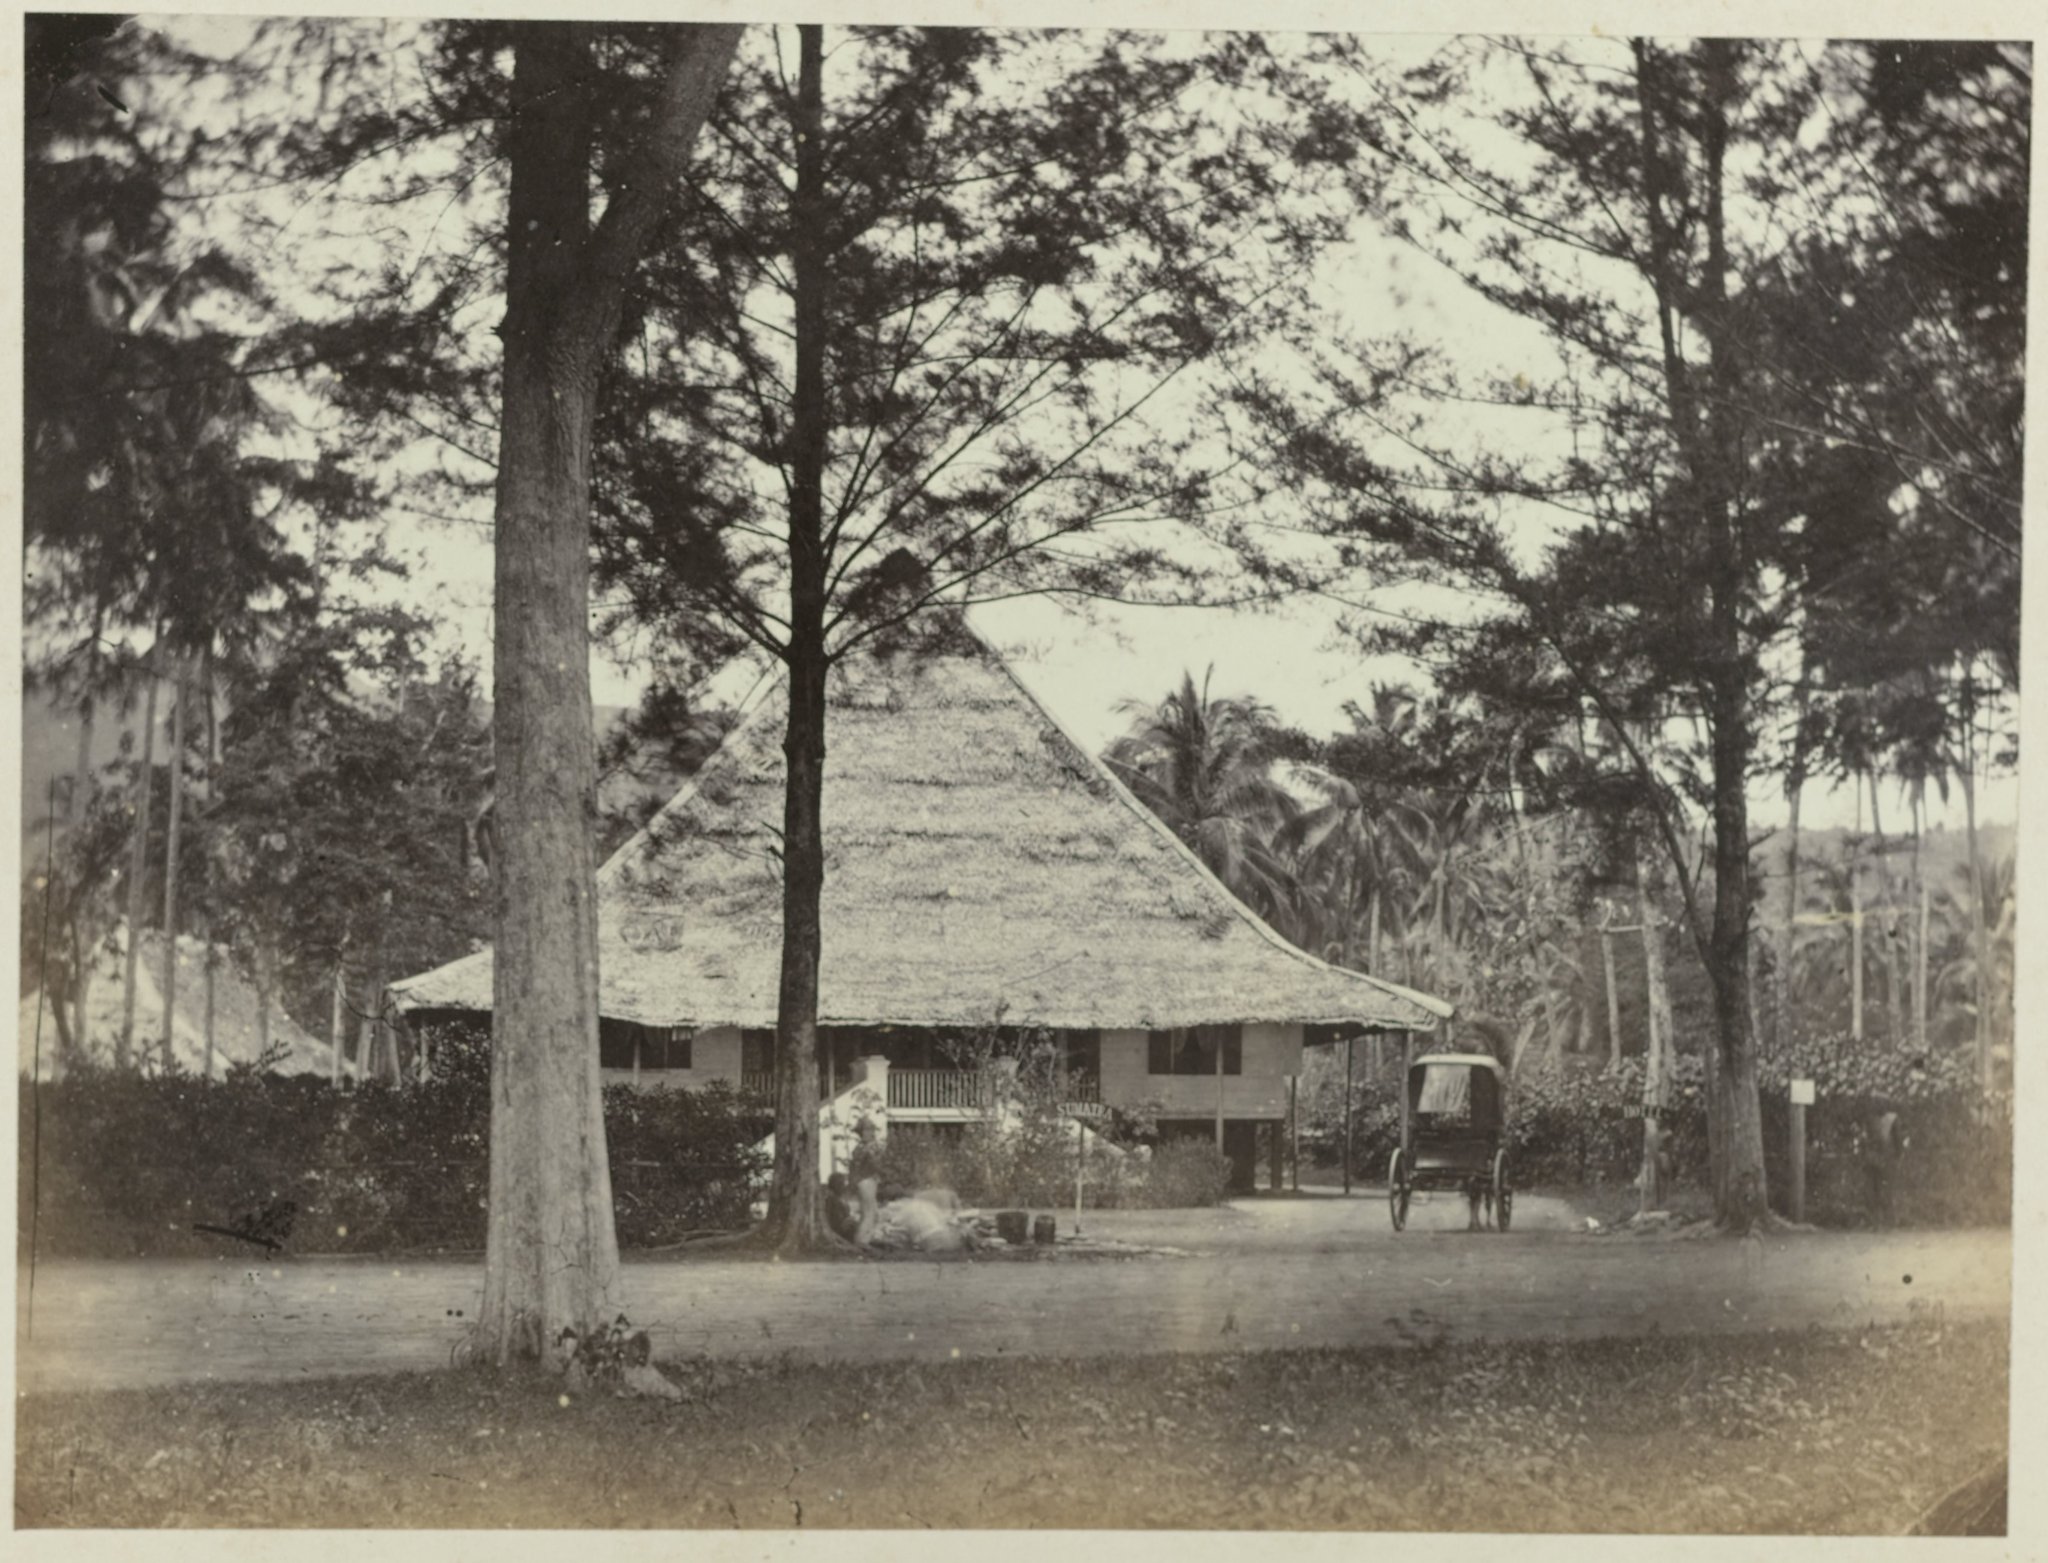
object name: photograph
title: Huis met koets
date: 1863-1869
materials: photographic support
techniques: albumen print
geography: padang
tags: country-house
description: Gezicht op een rijtuig voor Hotel Sumatra te Padang. Onderdeel van het groene fotoalbum met foto's van Java, uit het bezit van apotheker Specht-Grijp, die in 1865 vanuit Batavia naar Nederland terugkeerde.